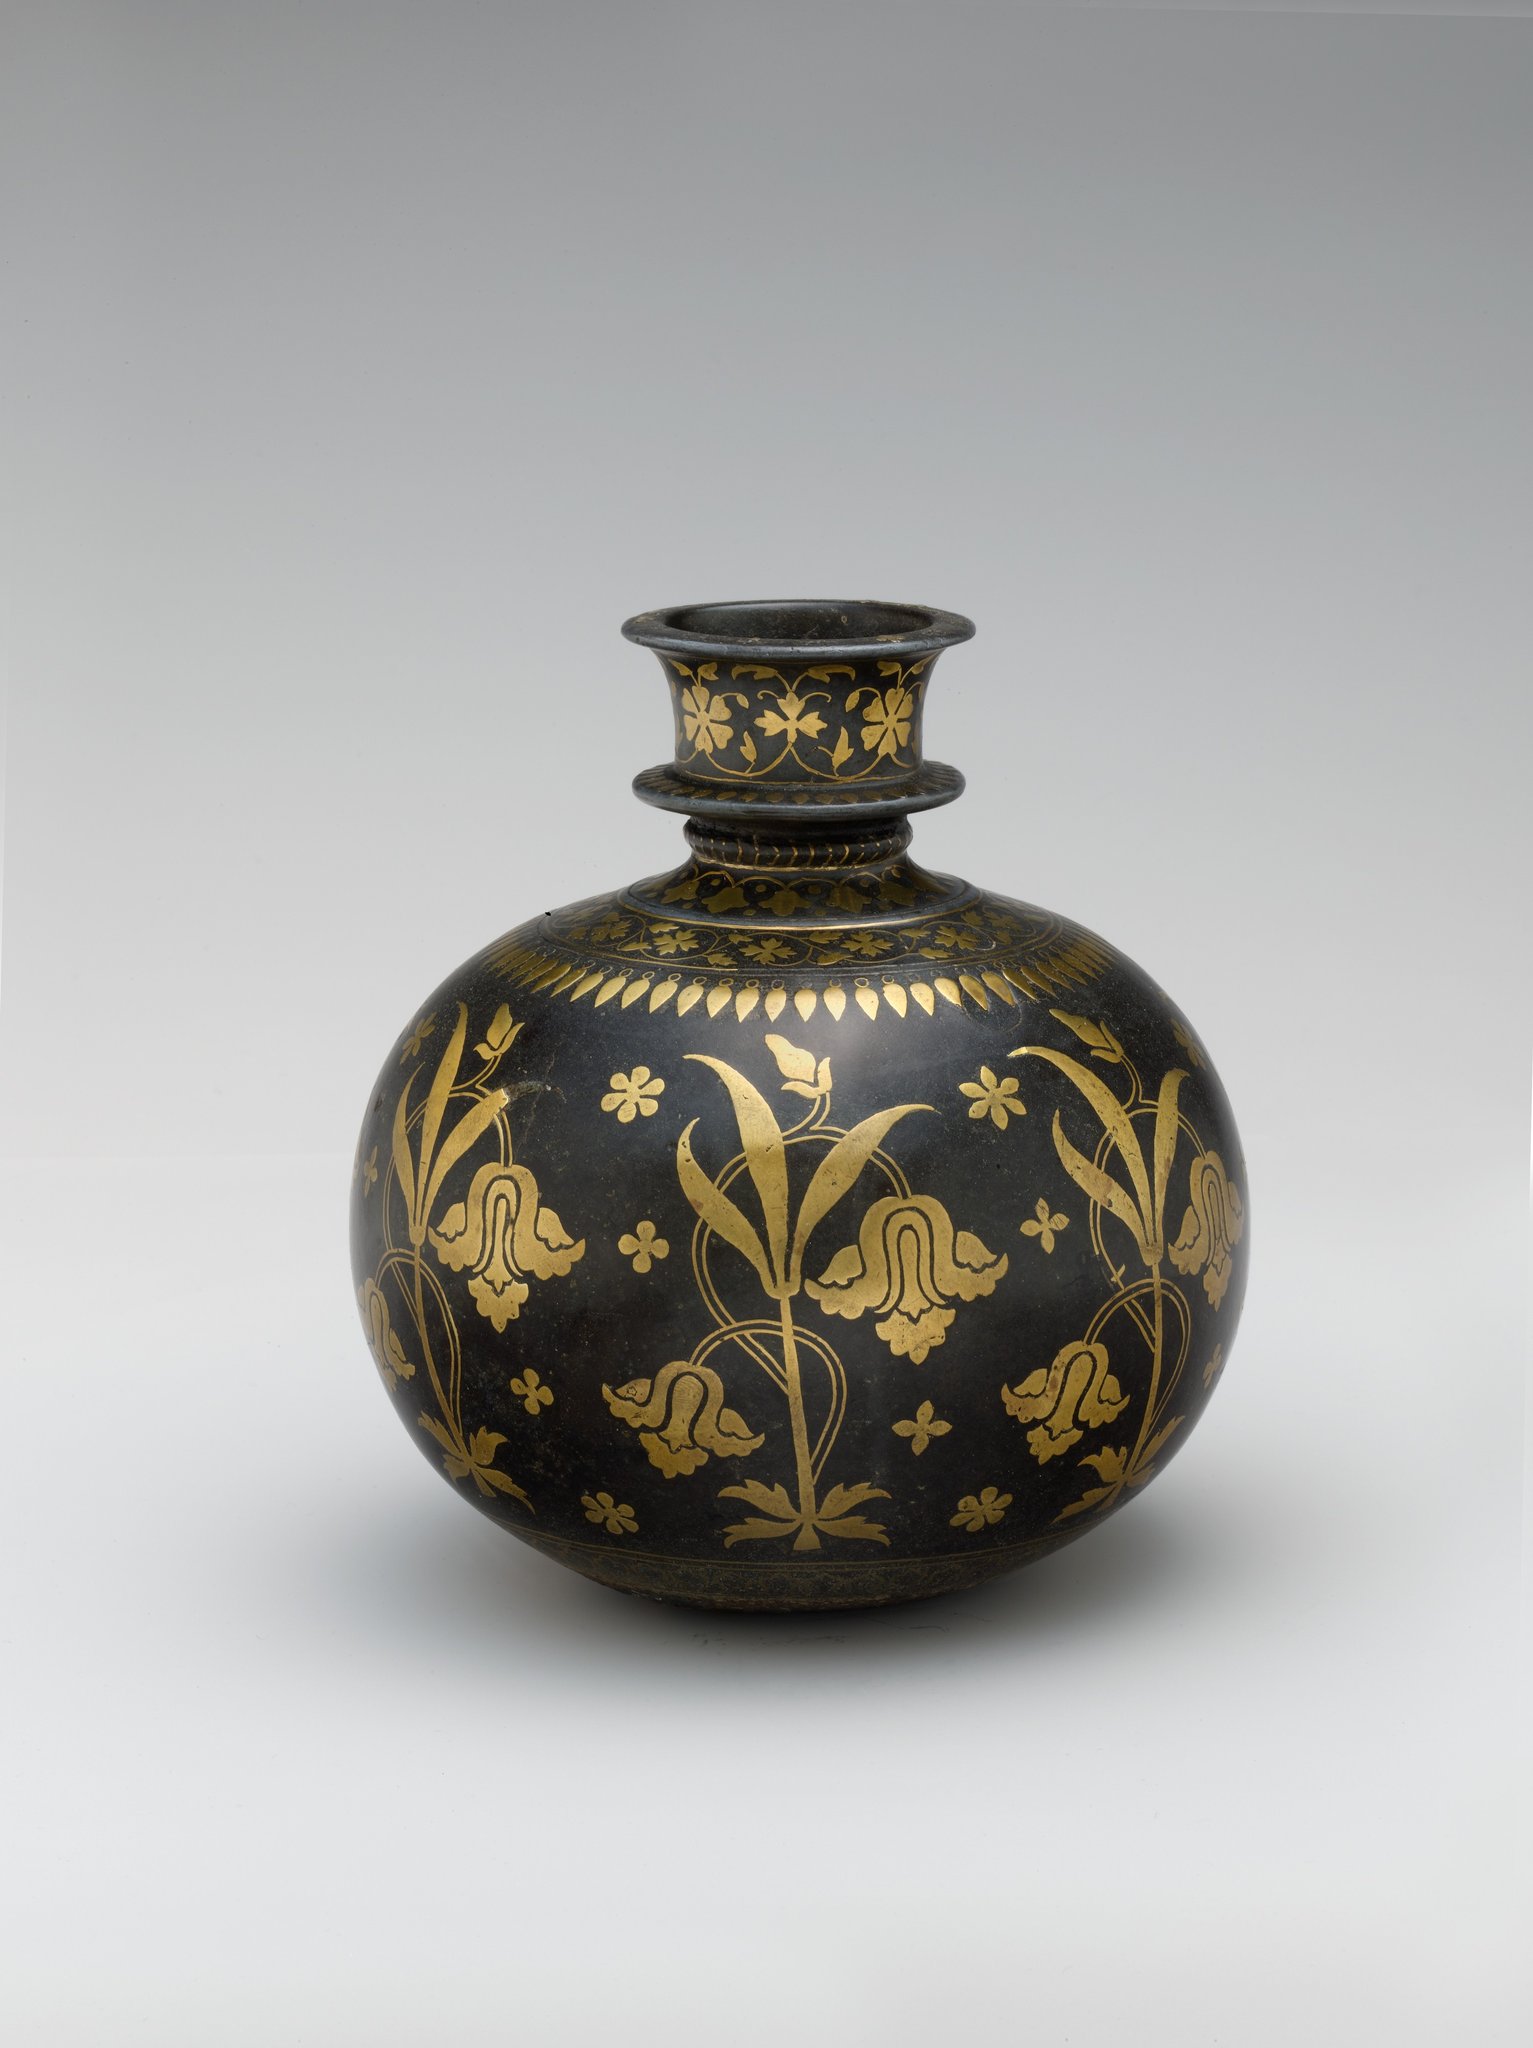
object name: water pipe base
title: Base for a Water Pipe (Huqqa) with Irises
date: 1667-1700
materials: alloy, brass, zinc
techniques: casting, engraving, inlay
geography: india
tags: flowers